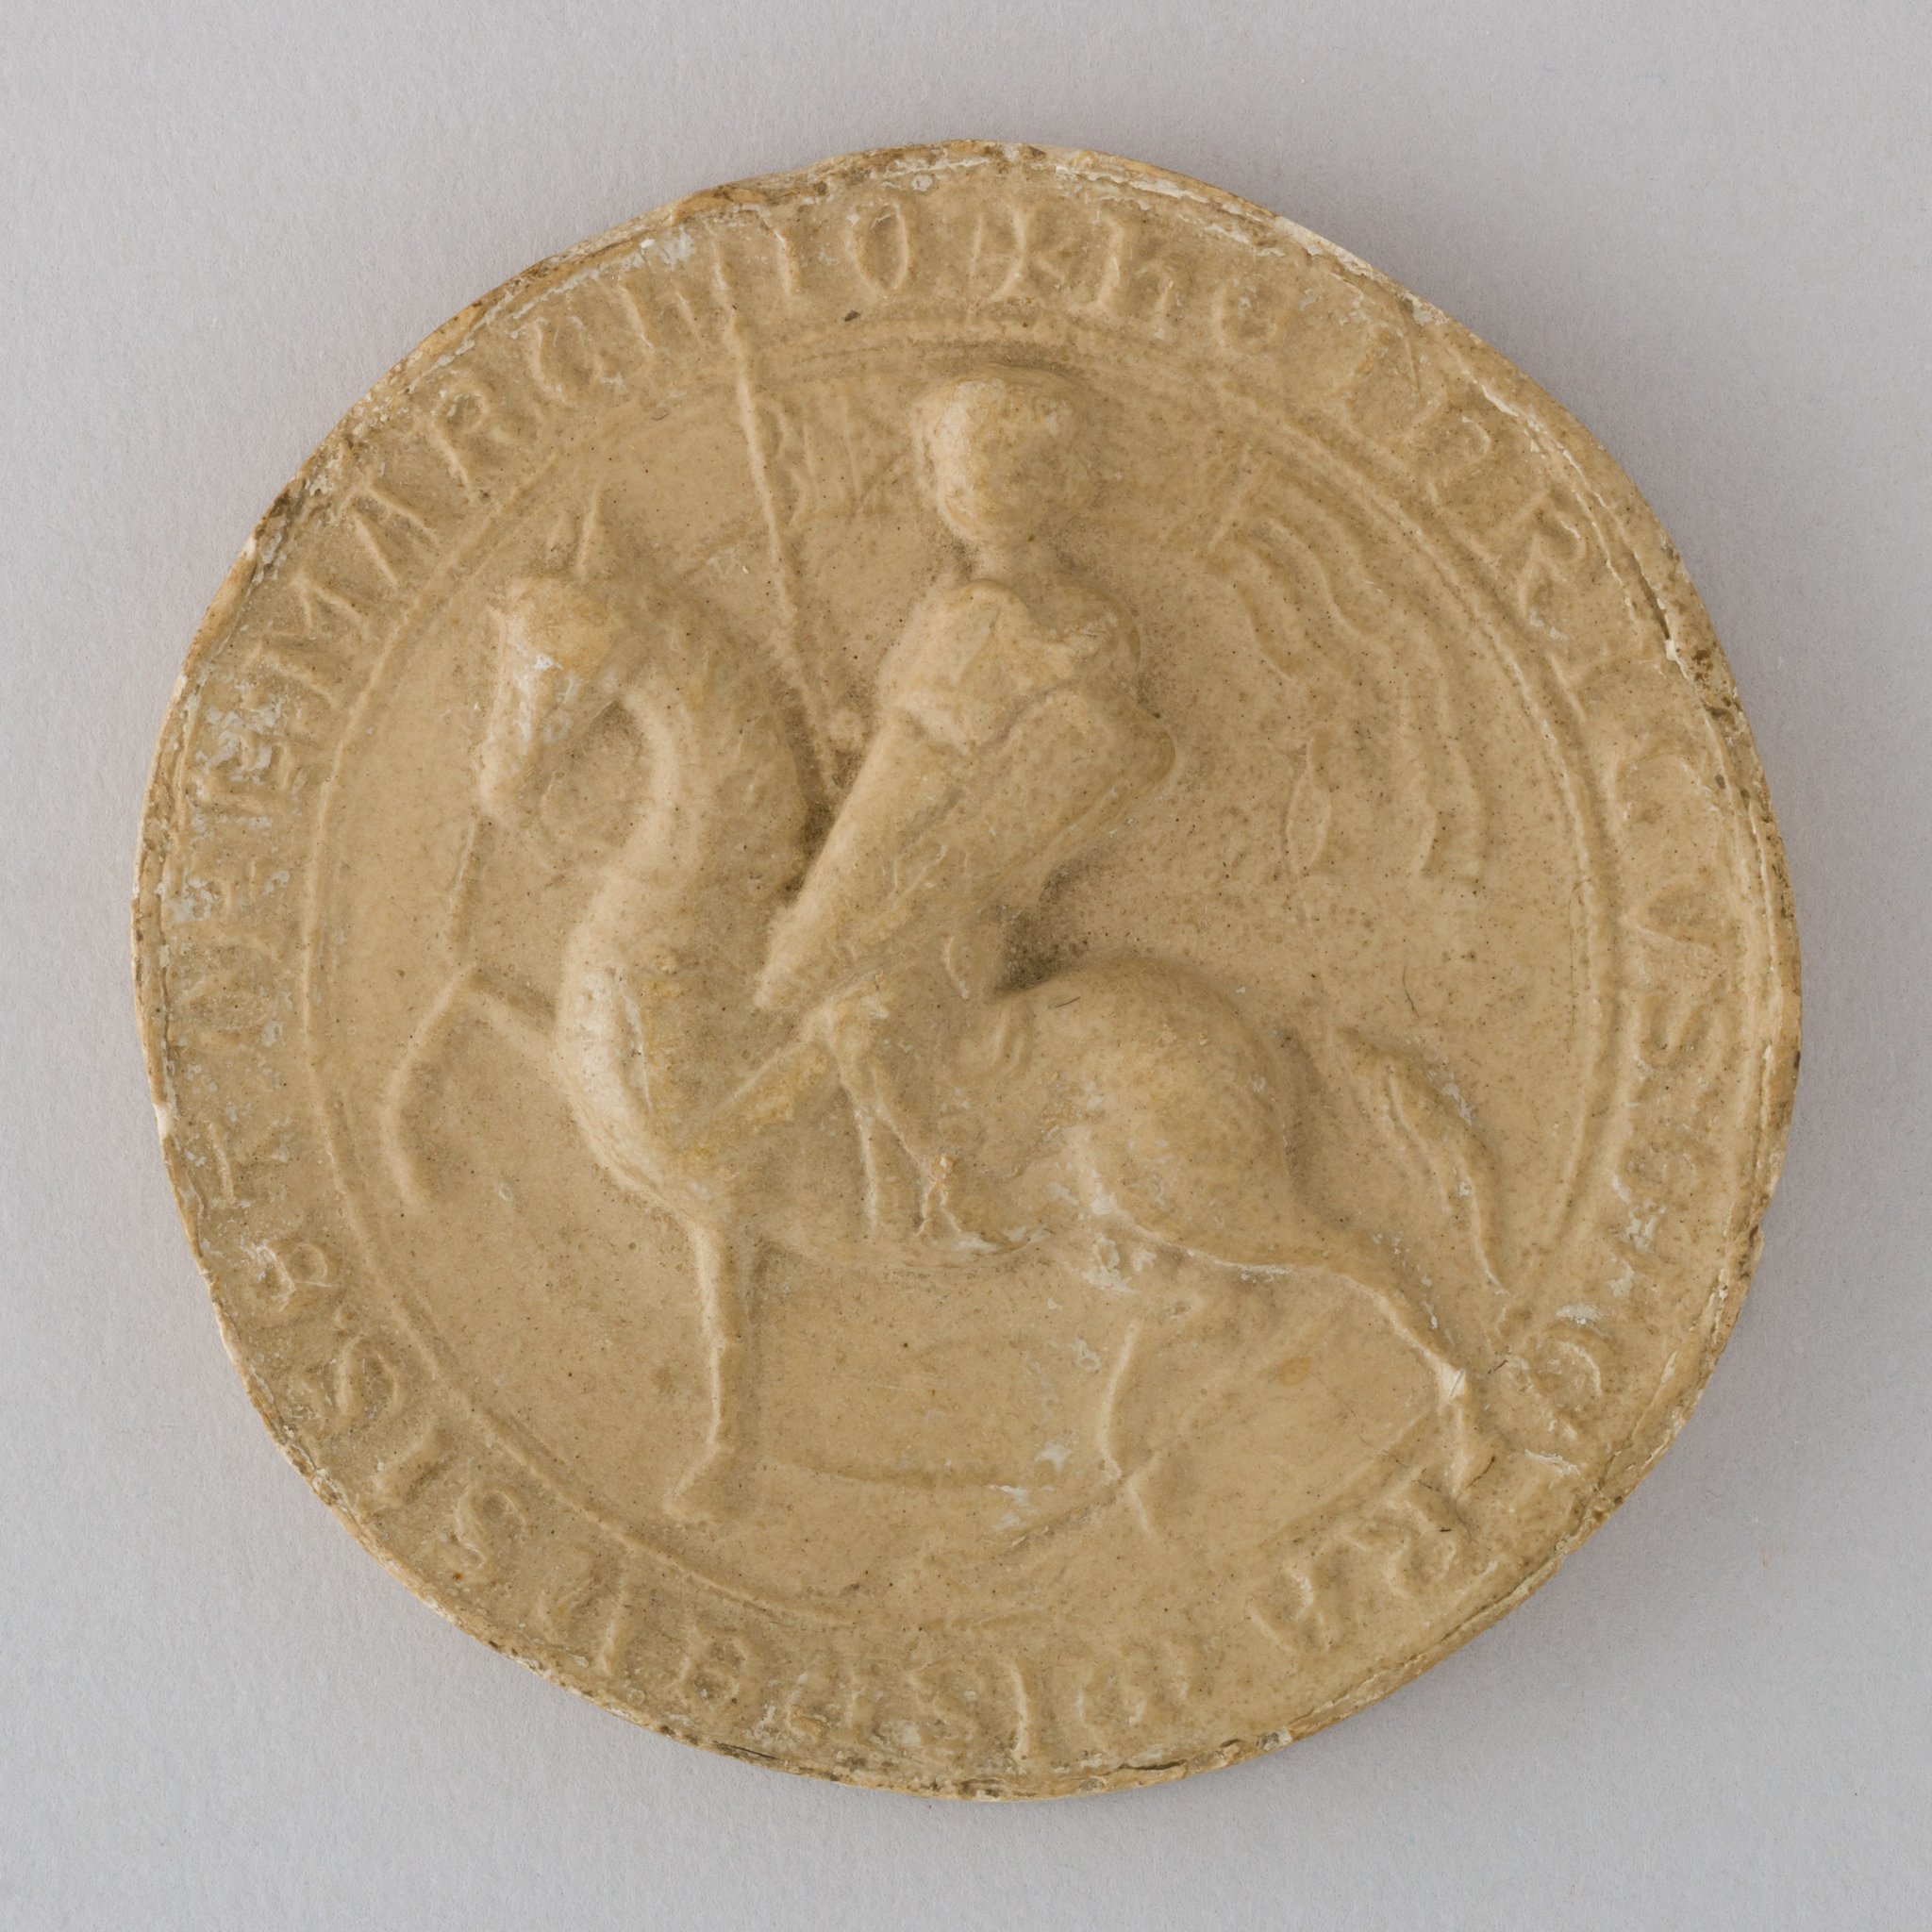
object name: seal reproduction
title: Reproduction of the Seal of Heinrich der Erlauchte von Meissen, 1222 (Thüringen, 1247)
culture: german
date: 1867-1933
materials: plaster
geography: germany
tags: horses